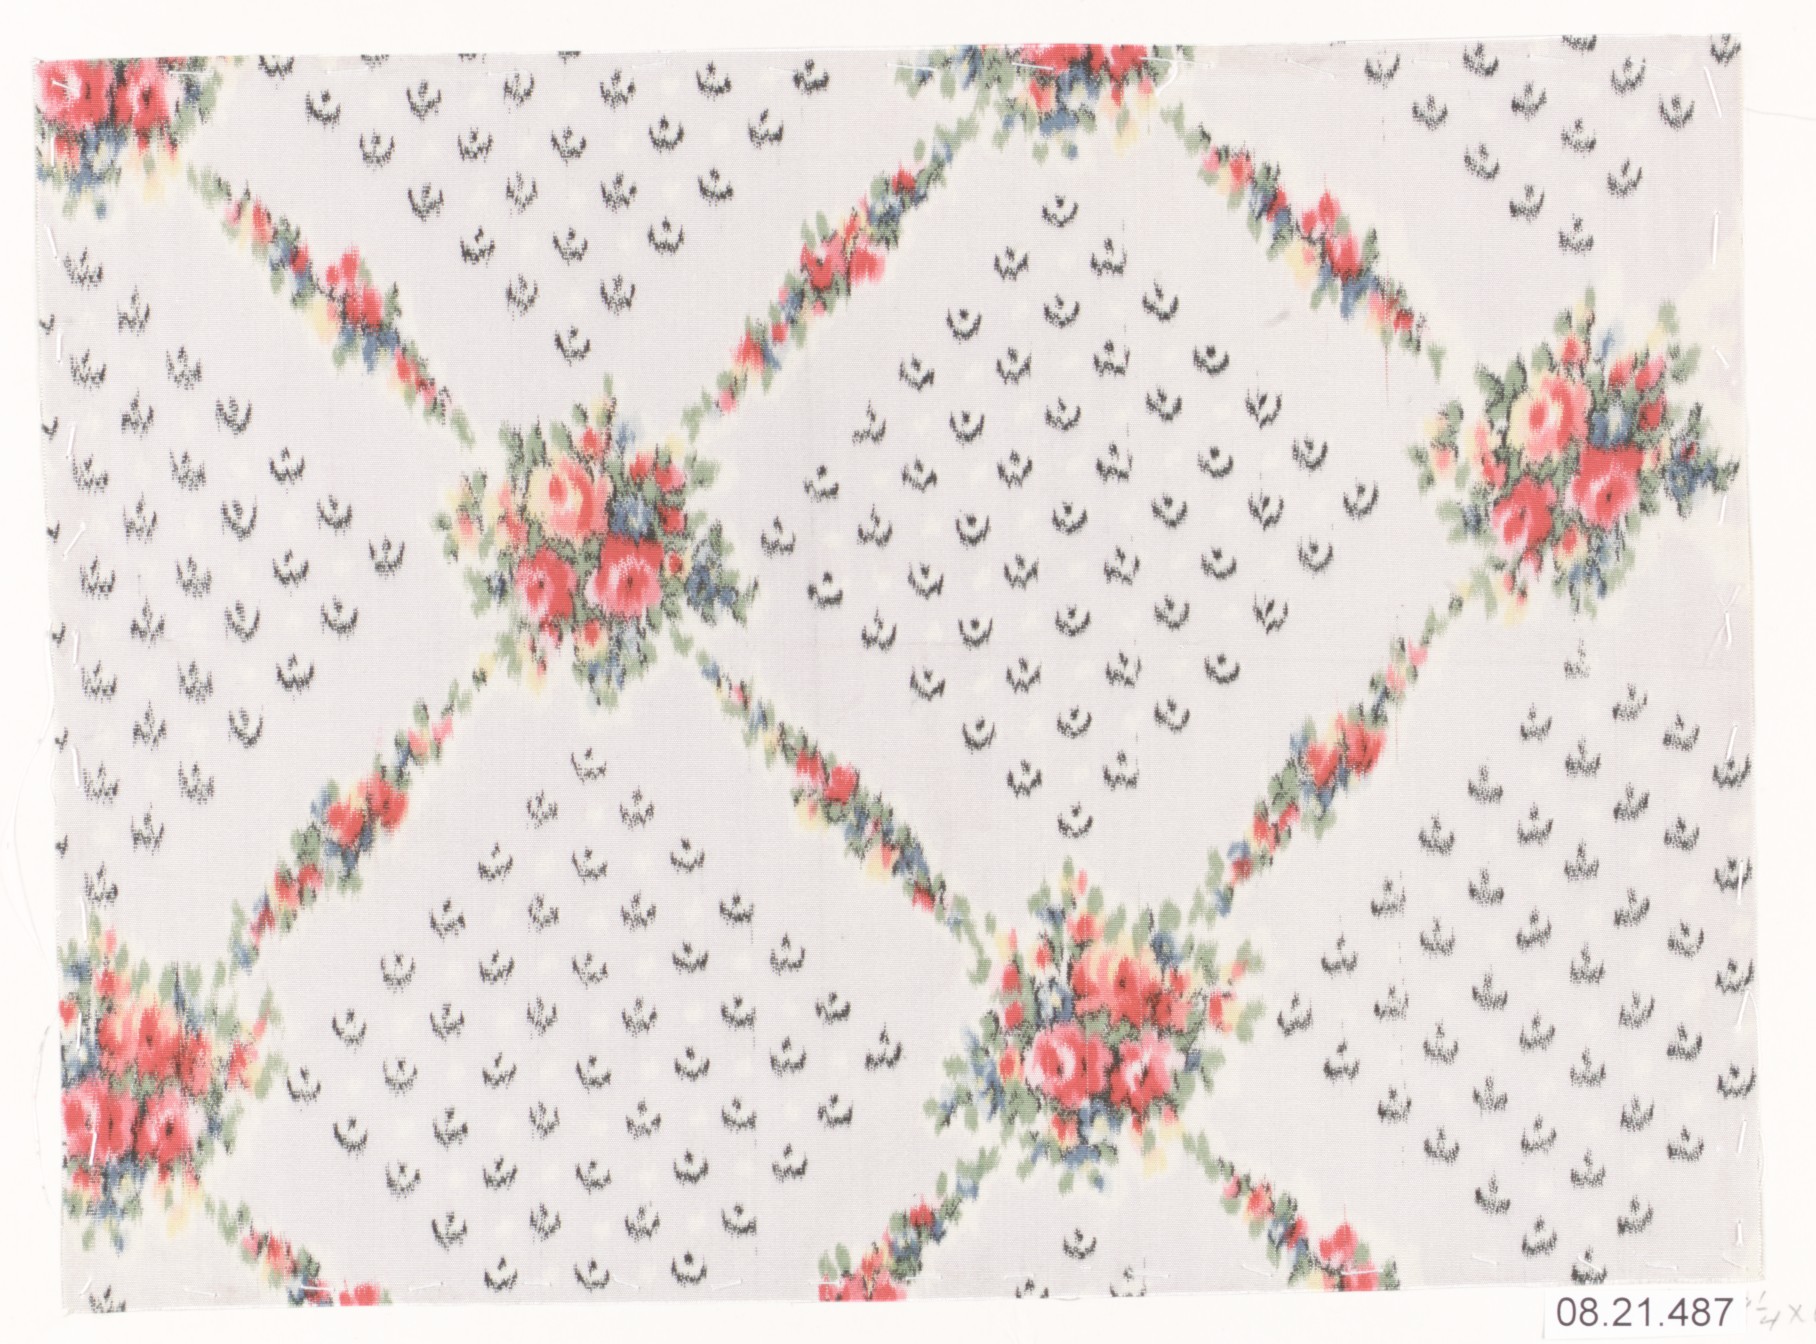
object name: textile sample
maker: Anonymous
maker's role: designer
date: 1900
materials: silk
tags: flowers